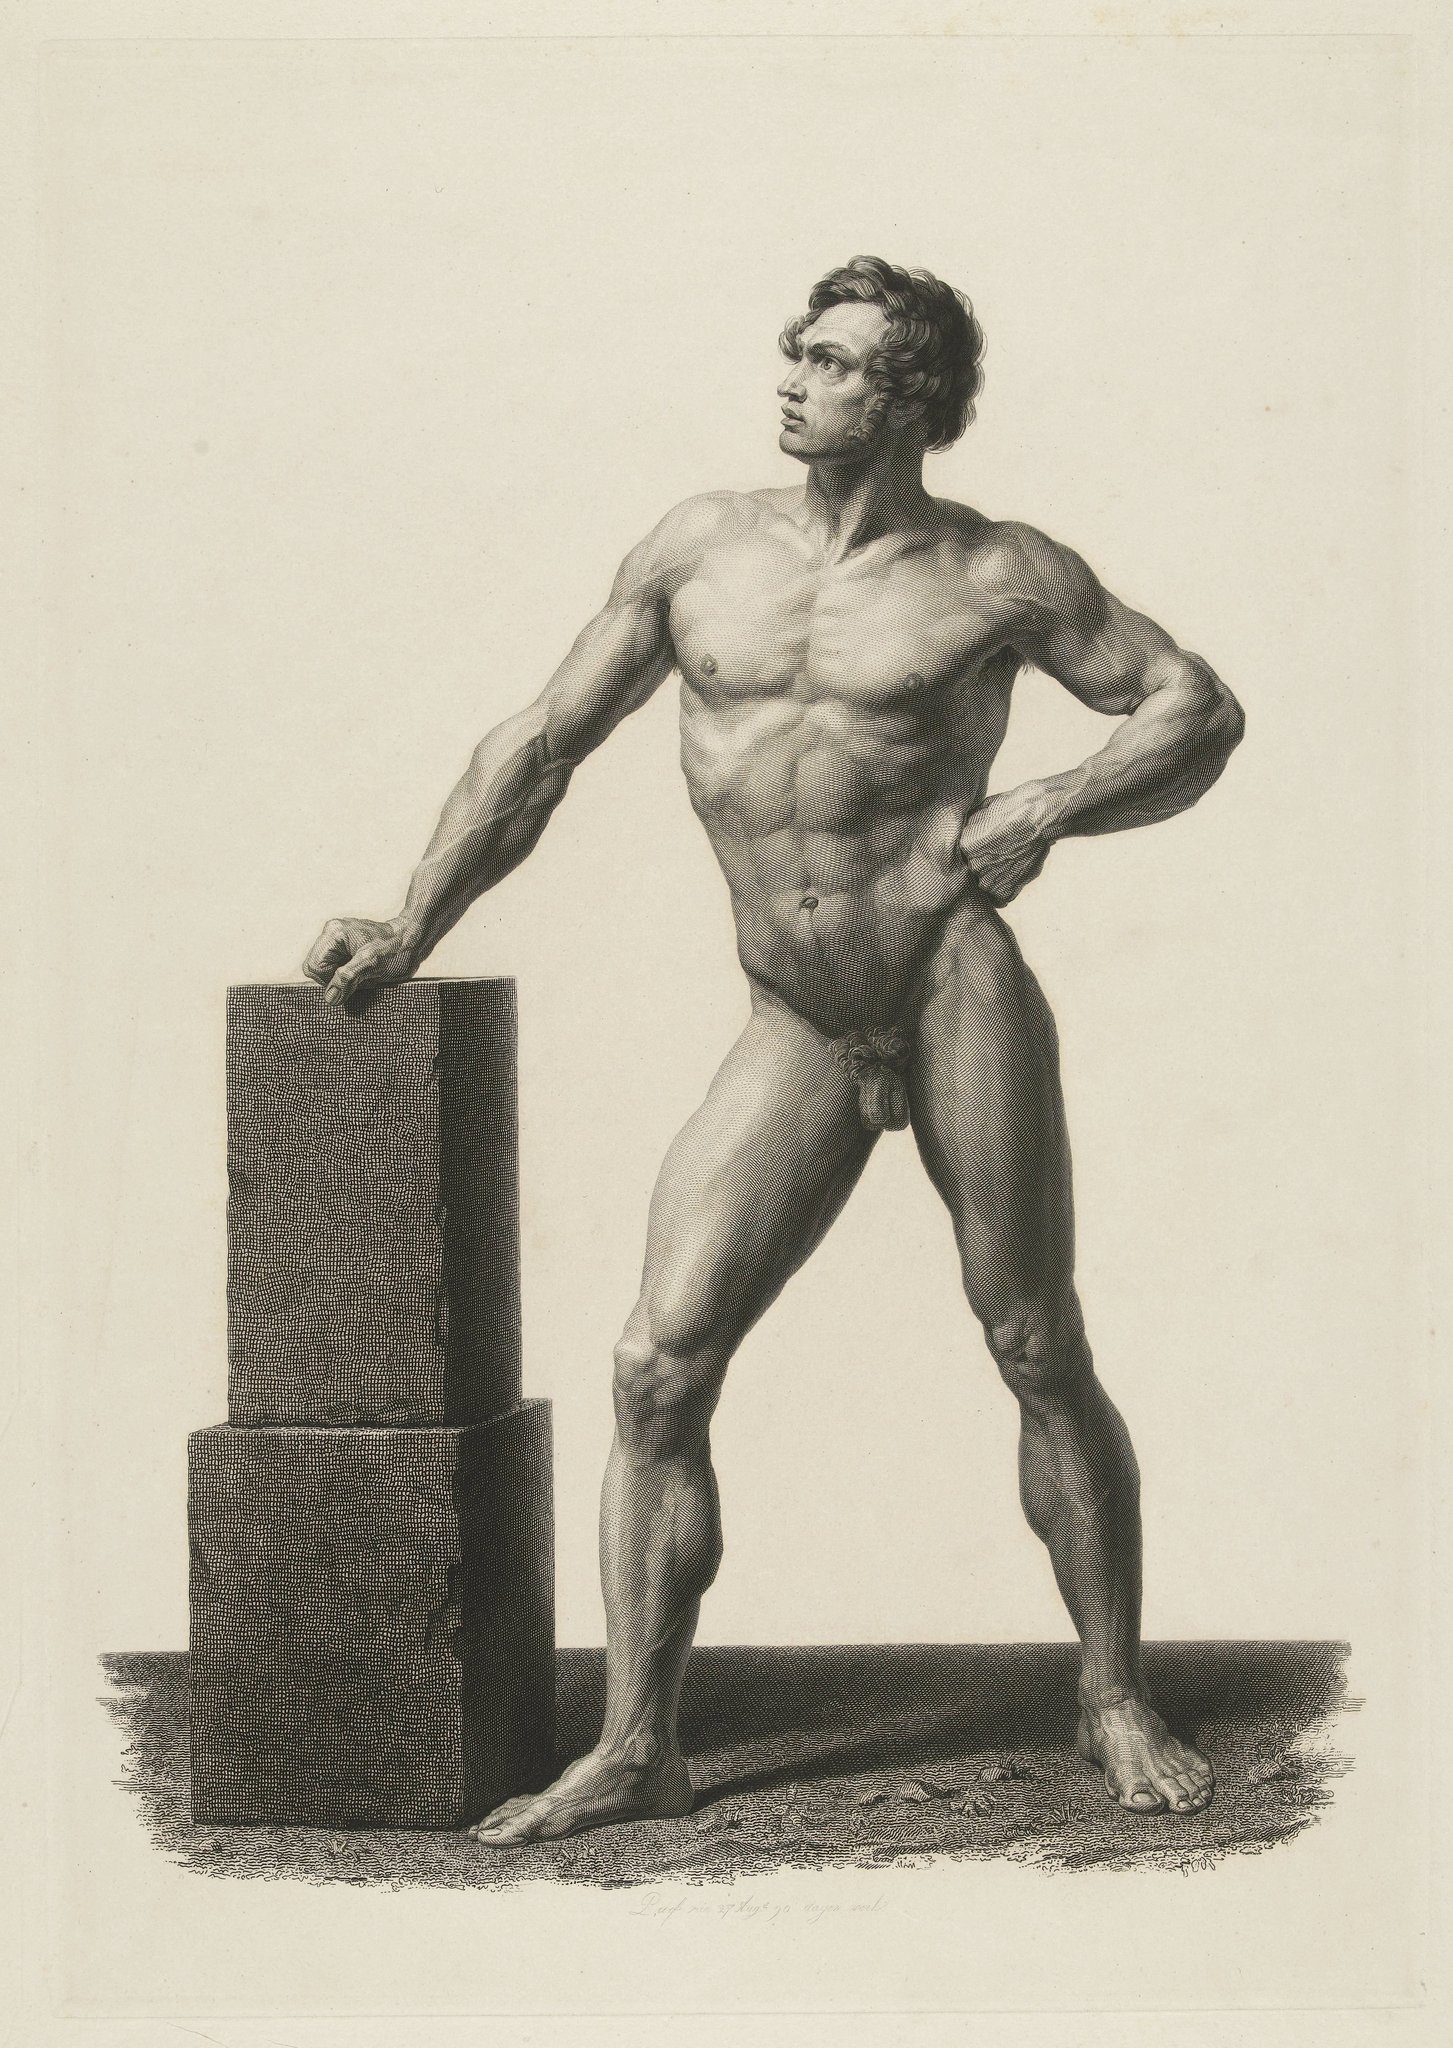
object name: print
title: Naakte man, met de rechterhand op een stenen blok leunend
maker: henricus wilhelmus couwenberg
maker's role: draughtsman, print maker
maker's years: 1814-1845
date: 1836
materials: paper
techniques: engraving, etching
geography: amsterdam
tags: the (nude) human figure; 'corpo humano' (ripa) (+ standing)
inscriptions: name: ‘D.J. Sluyter 27 Aug. 1836’, name: ‘J.P. Lange 27 Aug. 1836’, collector's mark: Lugt 2228